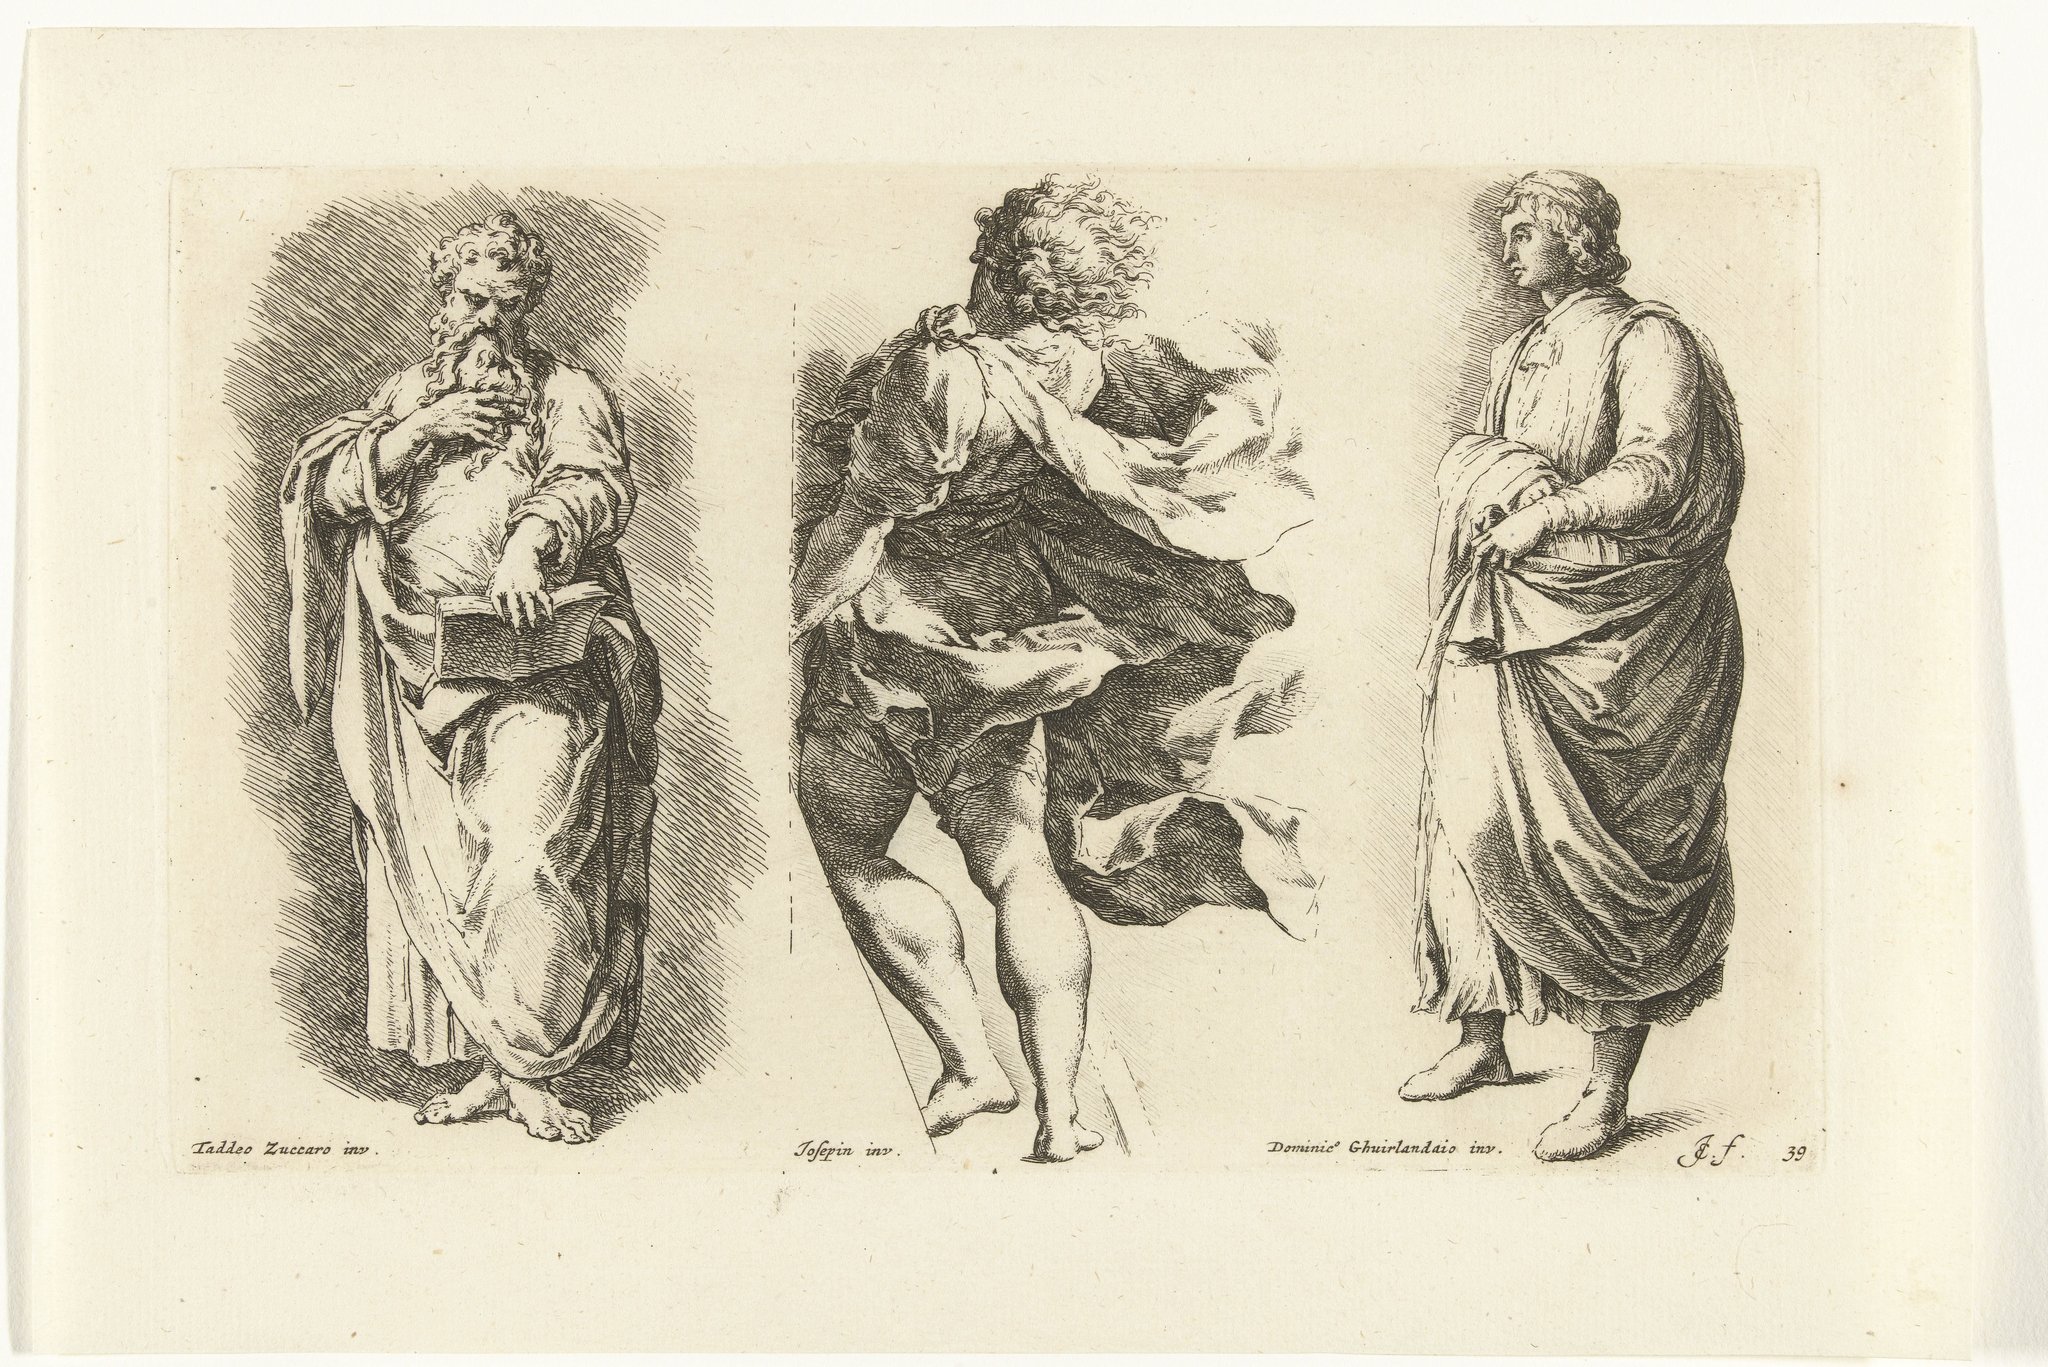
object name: print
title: Drie staande mannen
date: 1668-1671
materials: paper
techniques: etching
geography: northern netherlands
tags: mark (marcus) the evangelist, and bishop of alexandria; possible attributes: book, (winged) lion, pen and inkhorn, scroll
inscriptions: collector's mark: Lugt 2228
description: afkomstig uit: Paradigmata graphices variorum artificum : voor-beelden der teken-konst van verscheyde meesters, Hagae-Comitis, (2e of latere editie)